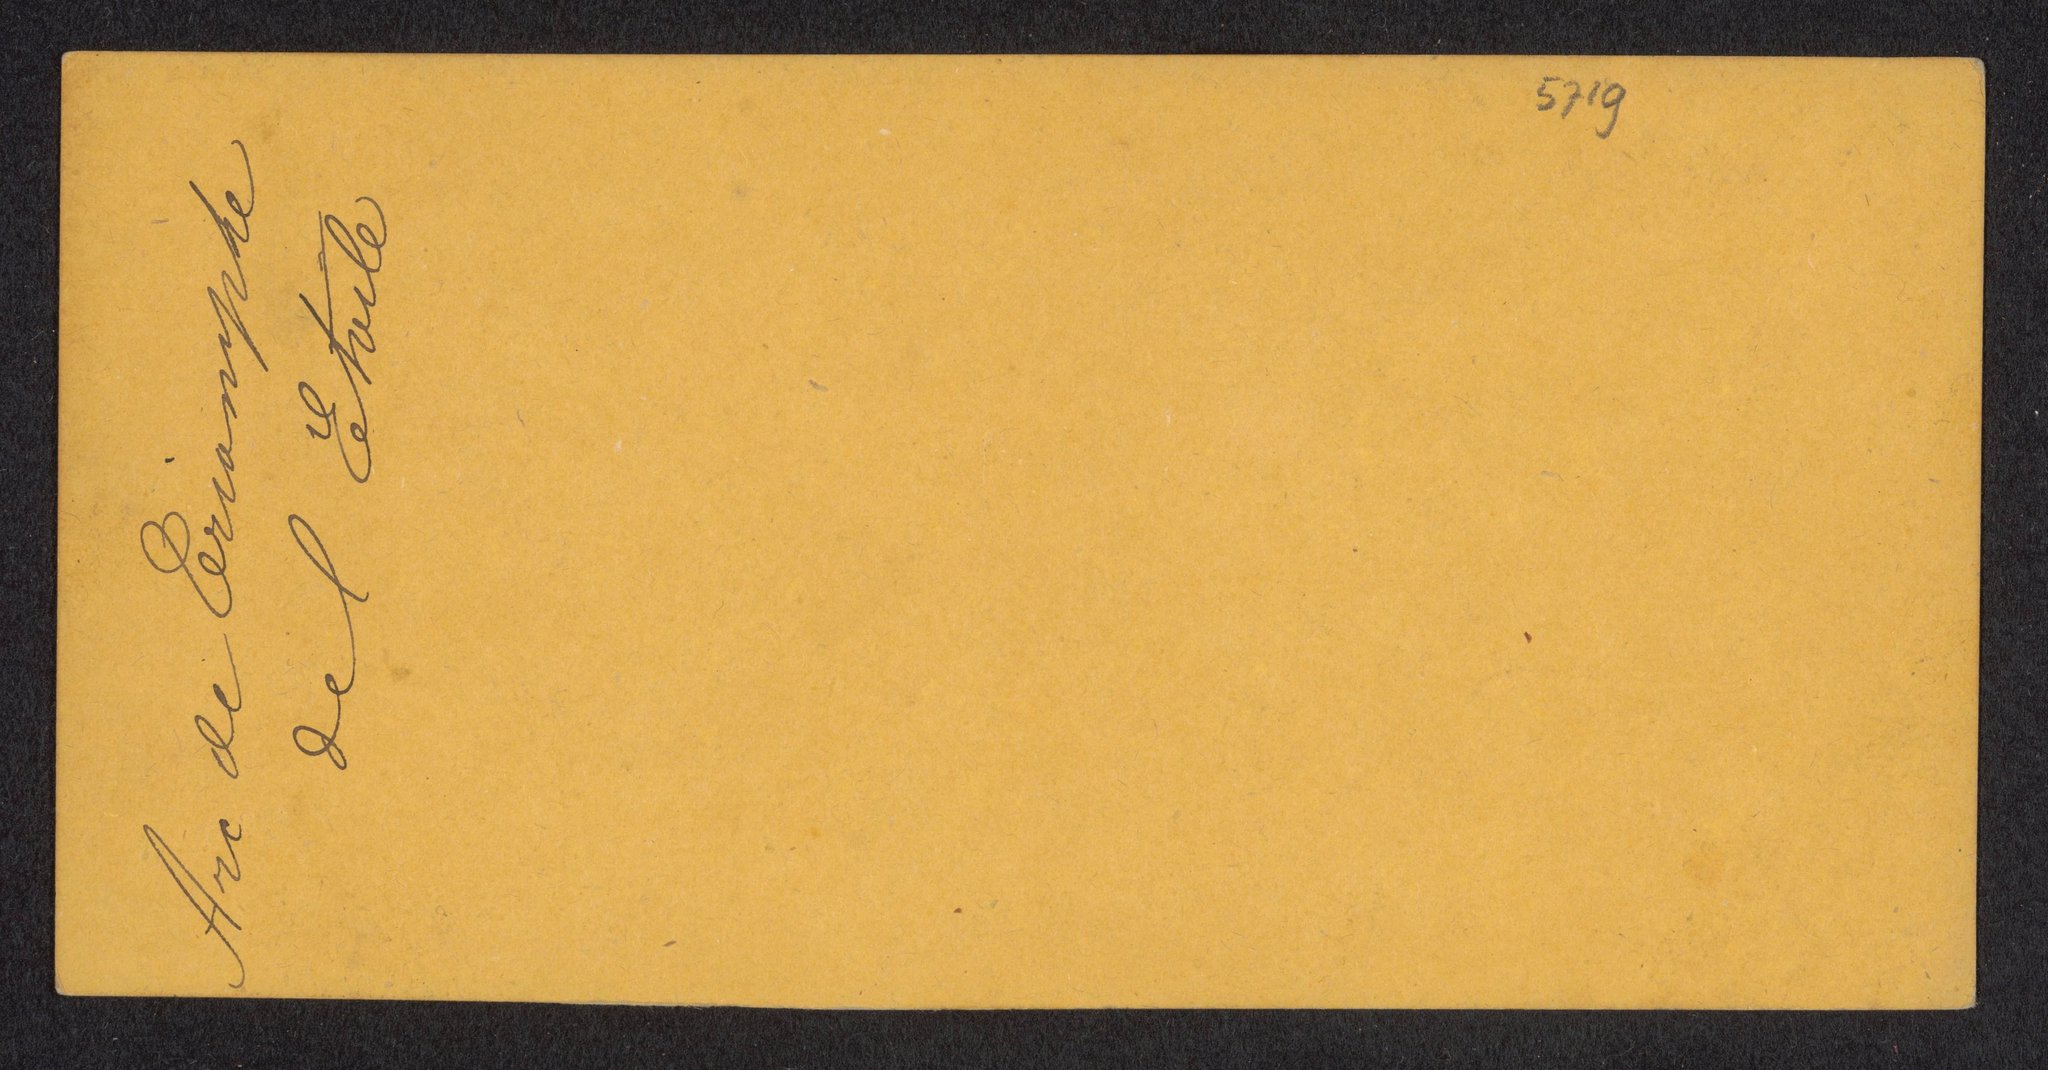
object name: stereograph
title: Gezicht op de Arc de Triomphe in Parijs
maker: Anonymous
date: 1850-1880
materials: cardboard, photographic support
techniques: albumen print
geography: paris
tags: triumphal arch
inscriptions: inscription: ‘Arc de Triomphe de l'Etoile’